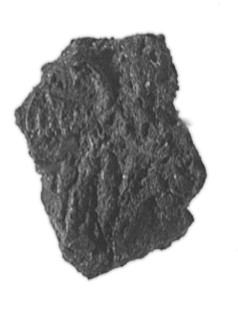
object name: sealing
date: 2030-1640 BCE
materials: clay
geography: egypt